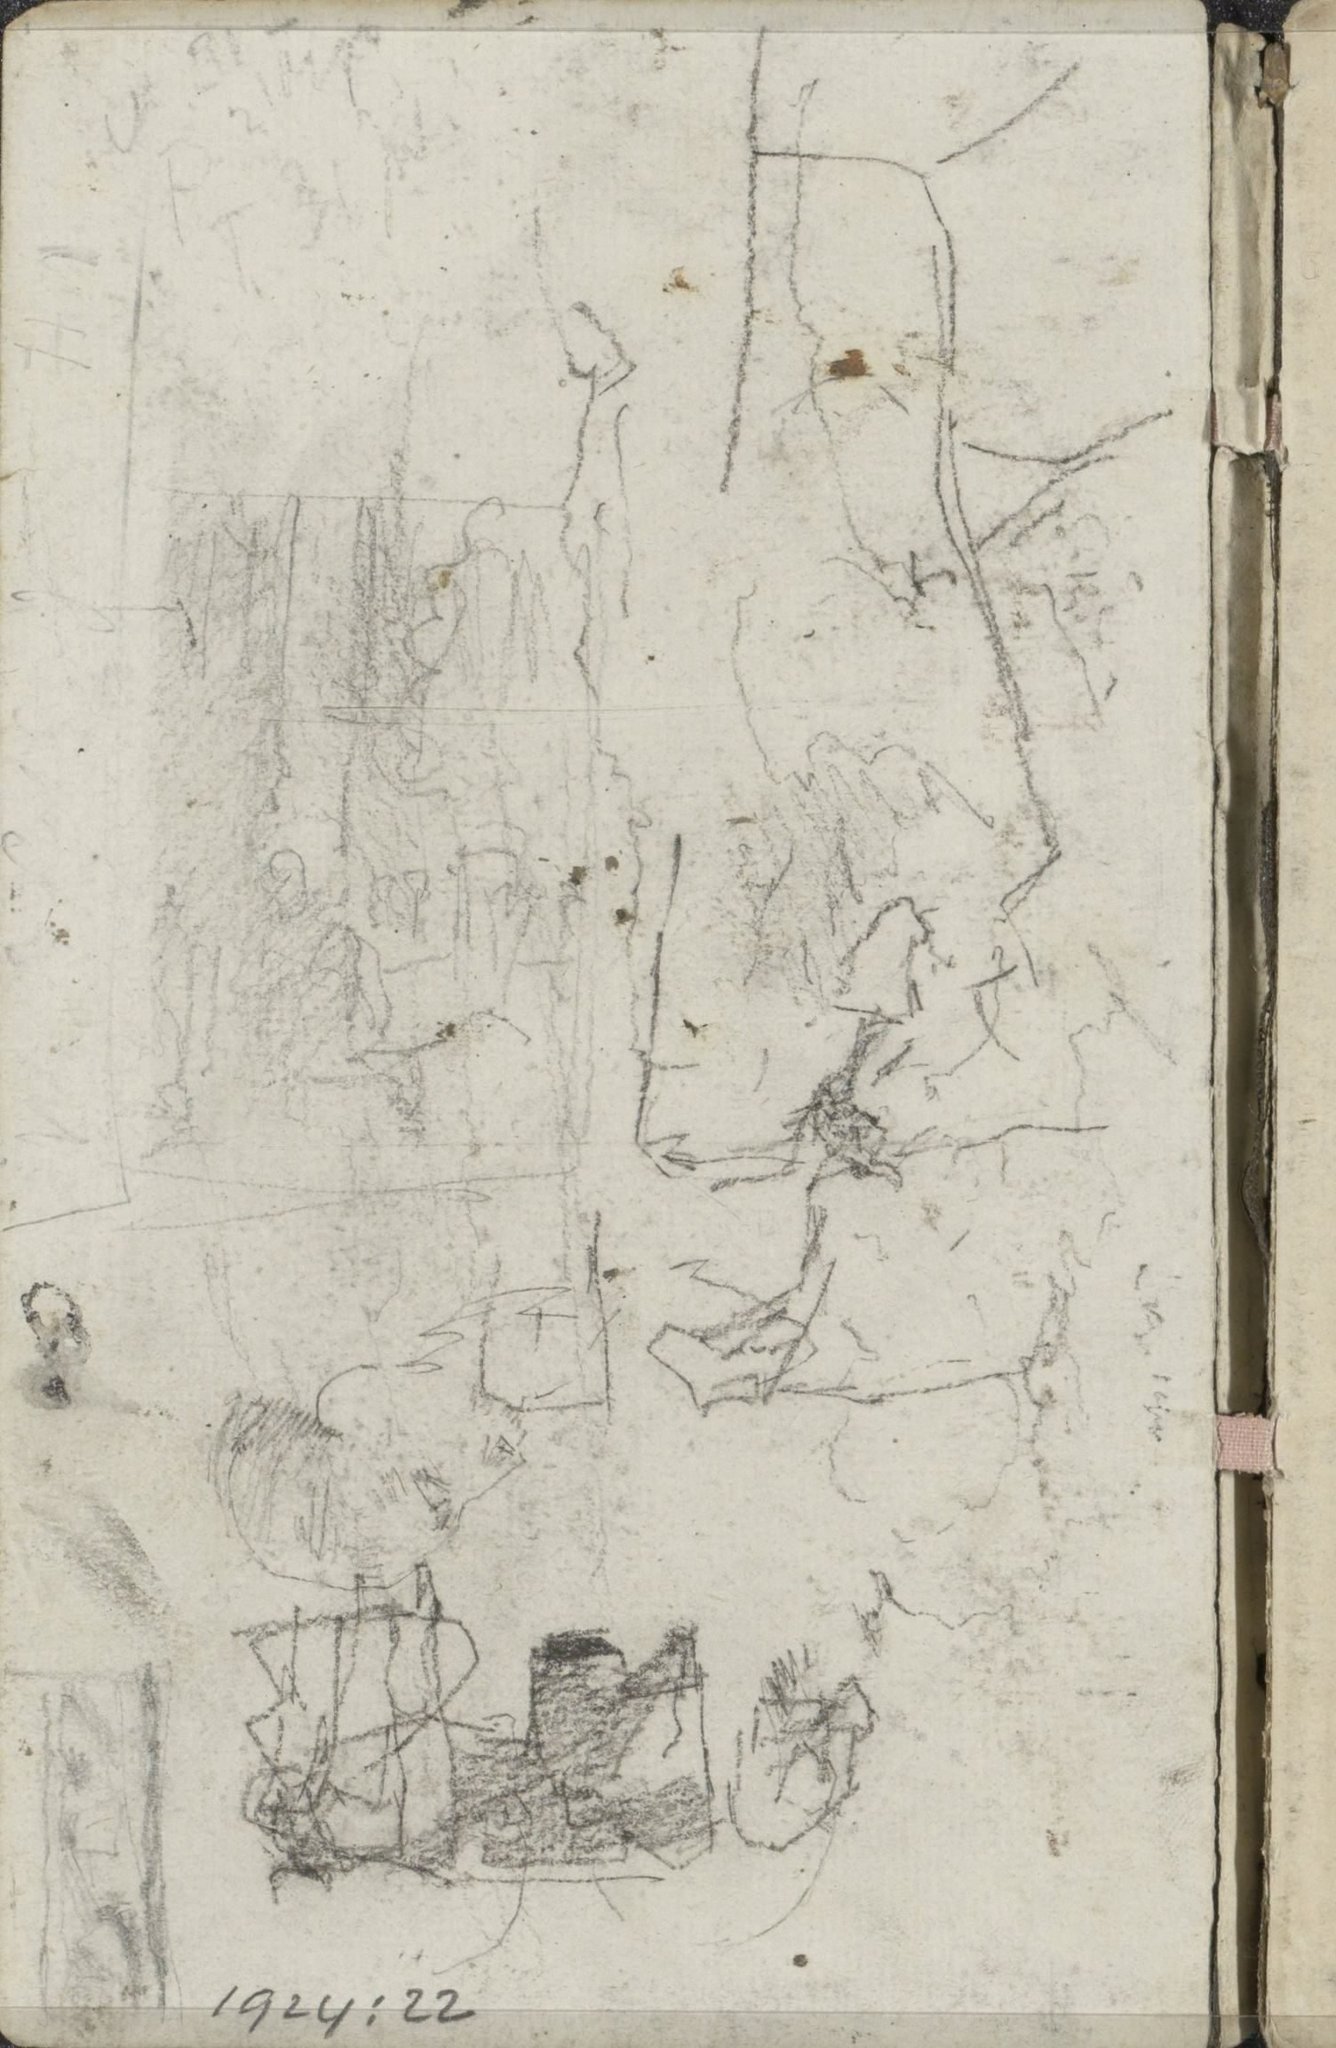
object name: sketchbook leaf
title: Studieblad, onder andere met koeien en figuren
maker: george hendrik breitner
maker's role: draughtsman, painter, print maker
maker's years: 1857-1923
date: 1880-1882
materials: chalk, paper, pencil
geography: the hague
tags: head (human), cow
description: Pagina 1, voorste schutblad, uit een schetsboek met 23 bladen.